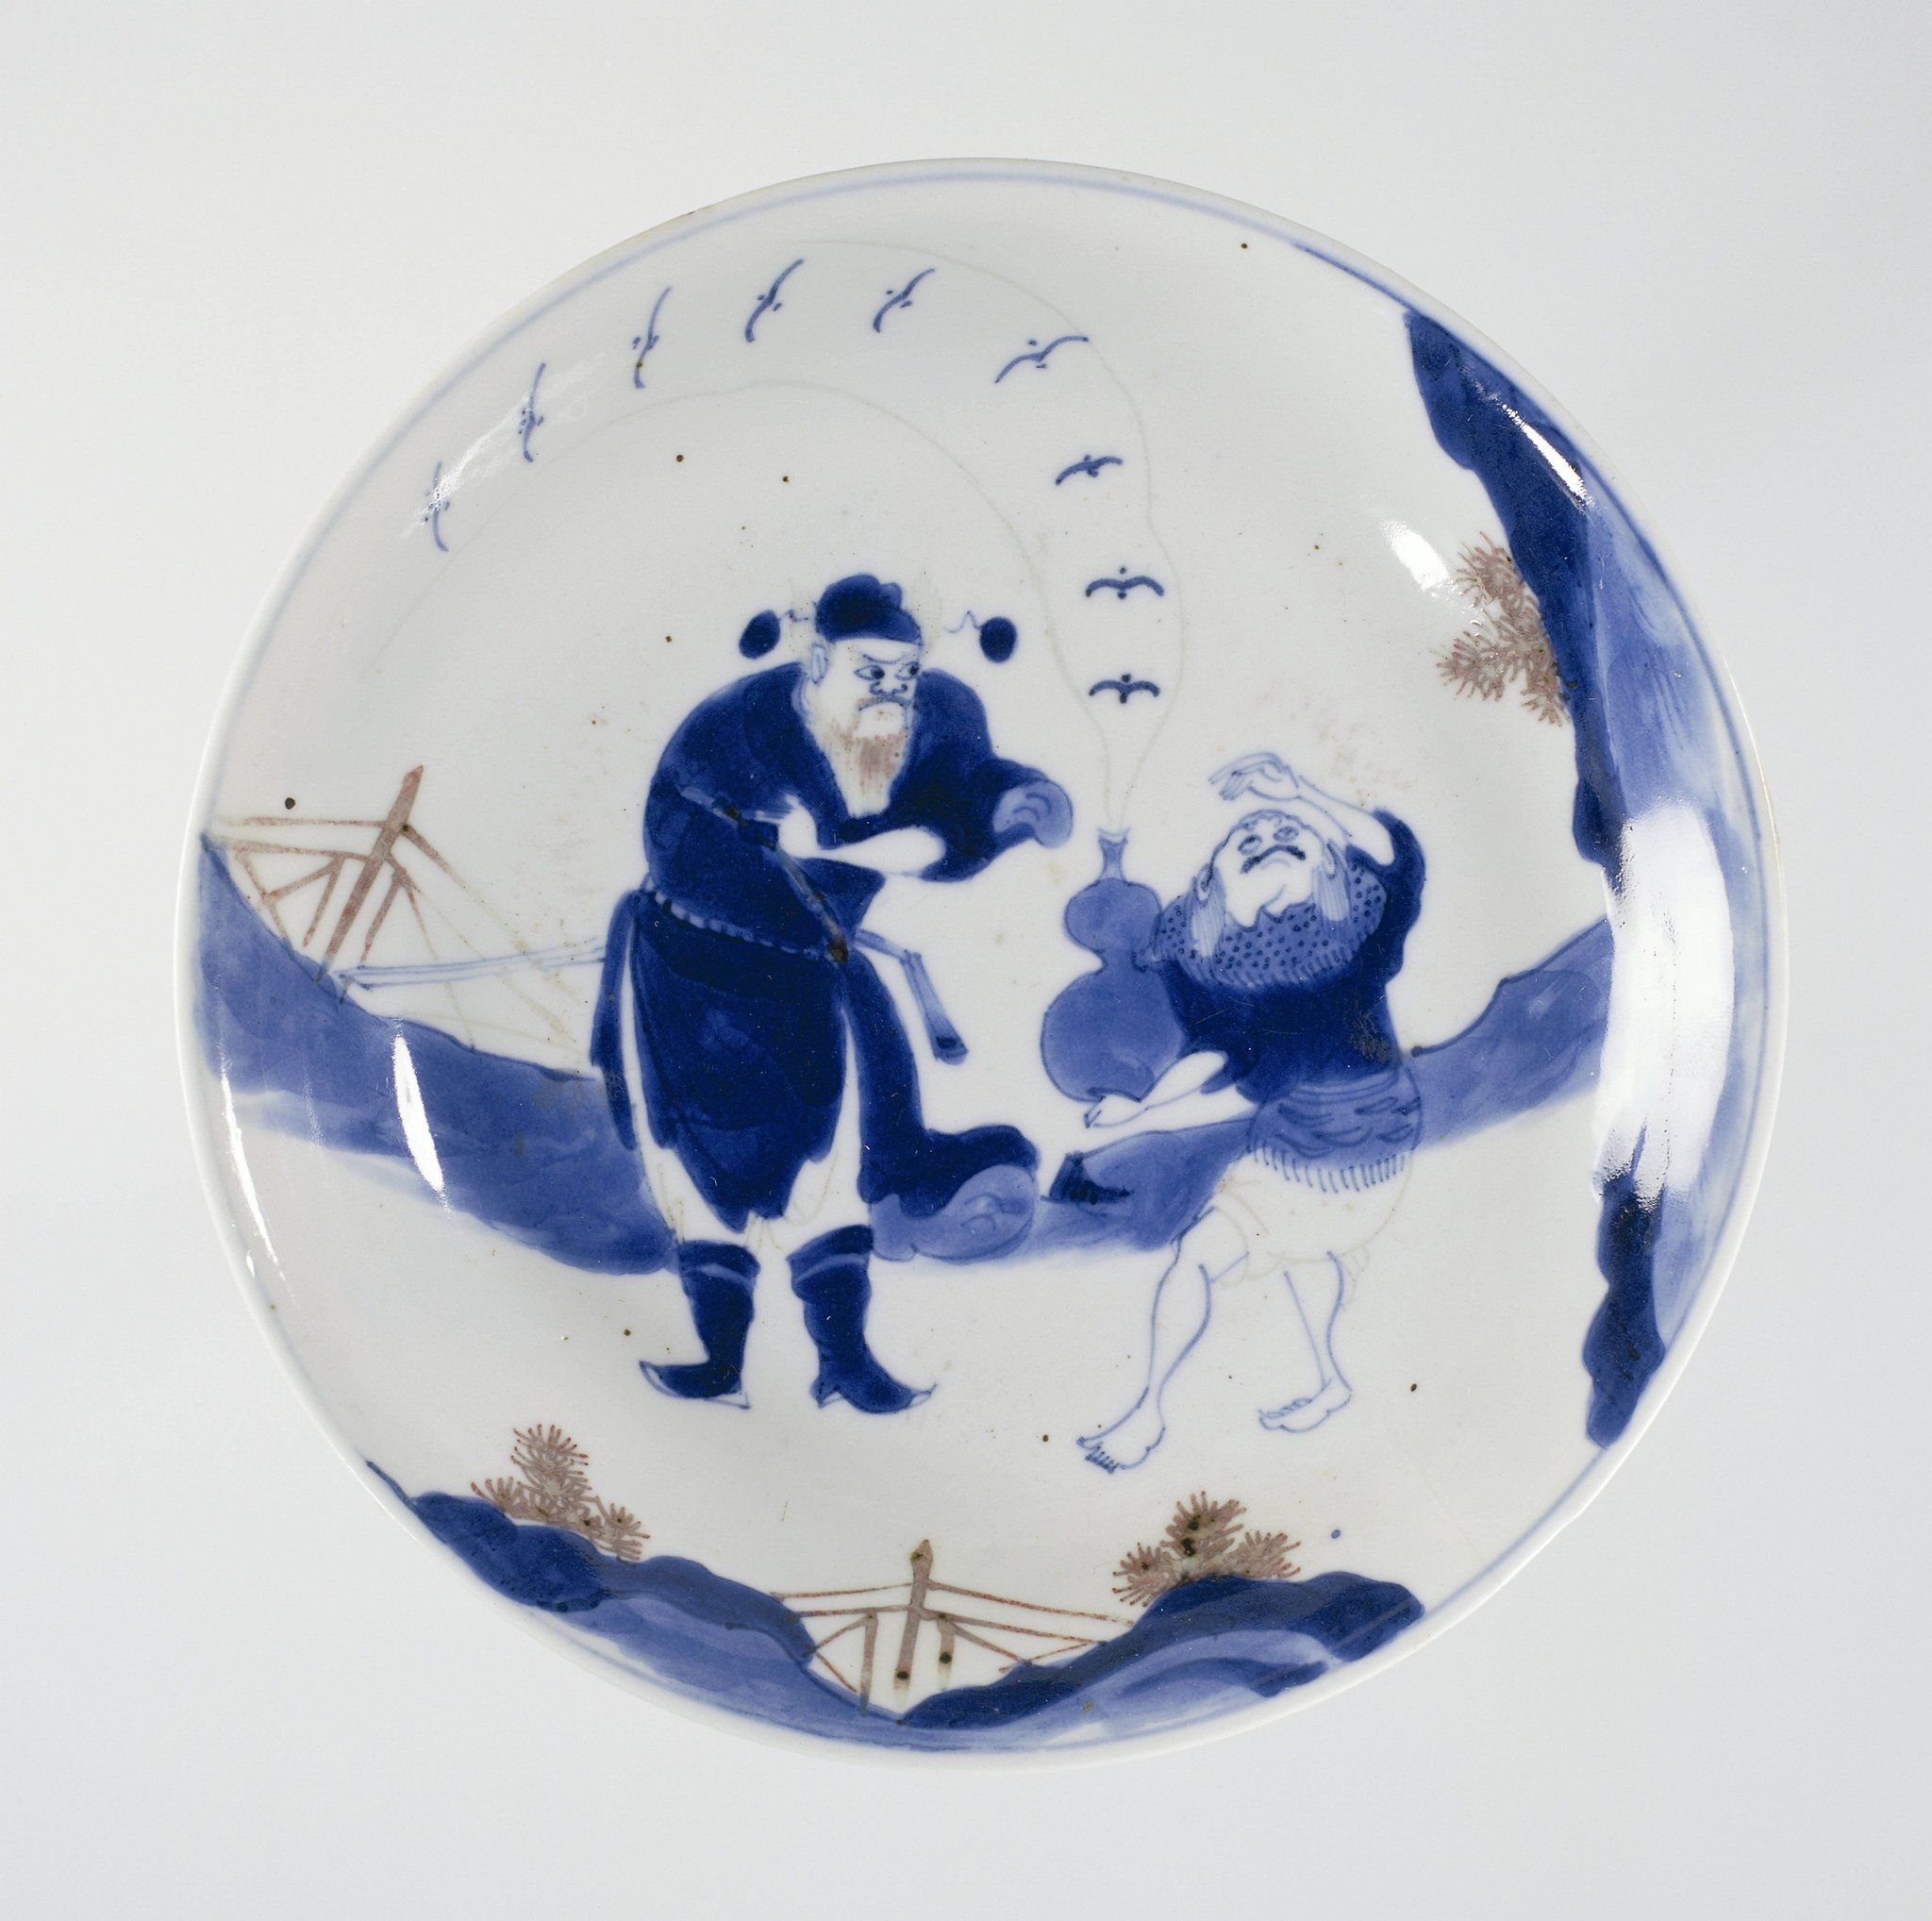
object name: dish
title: Saucer-dish with two figures in a landscape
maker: Anonymous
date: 1675-1724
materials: cobalt, copper, glaze, paint, porcelain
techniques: firing, turning, vitrification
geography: china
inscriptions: mark